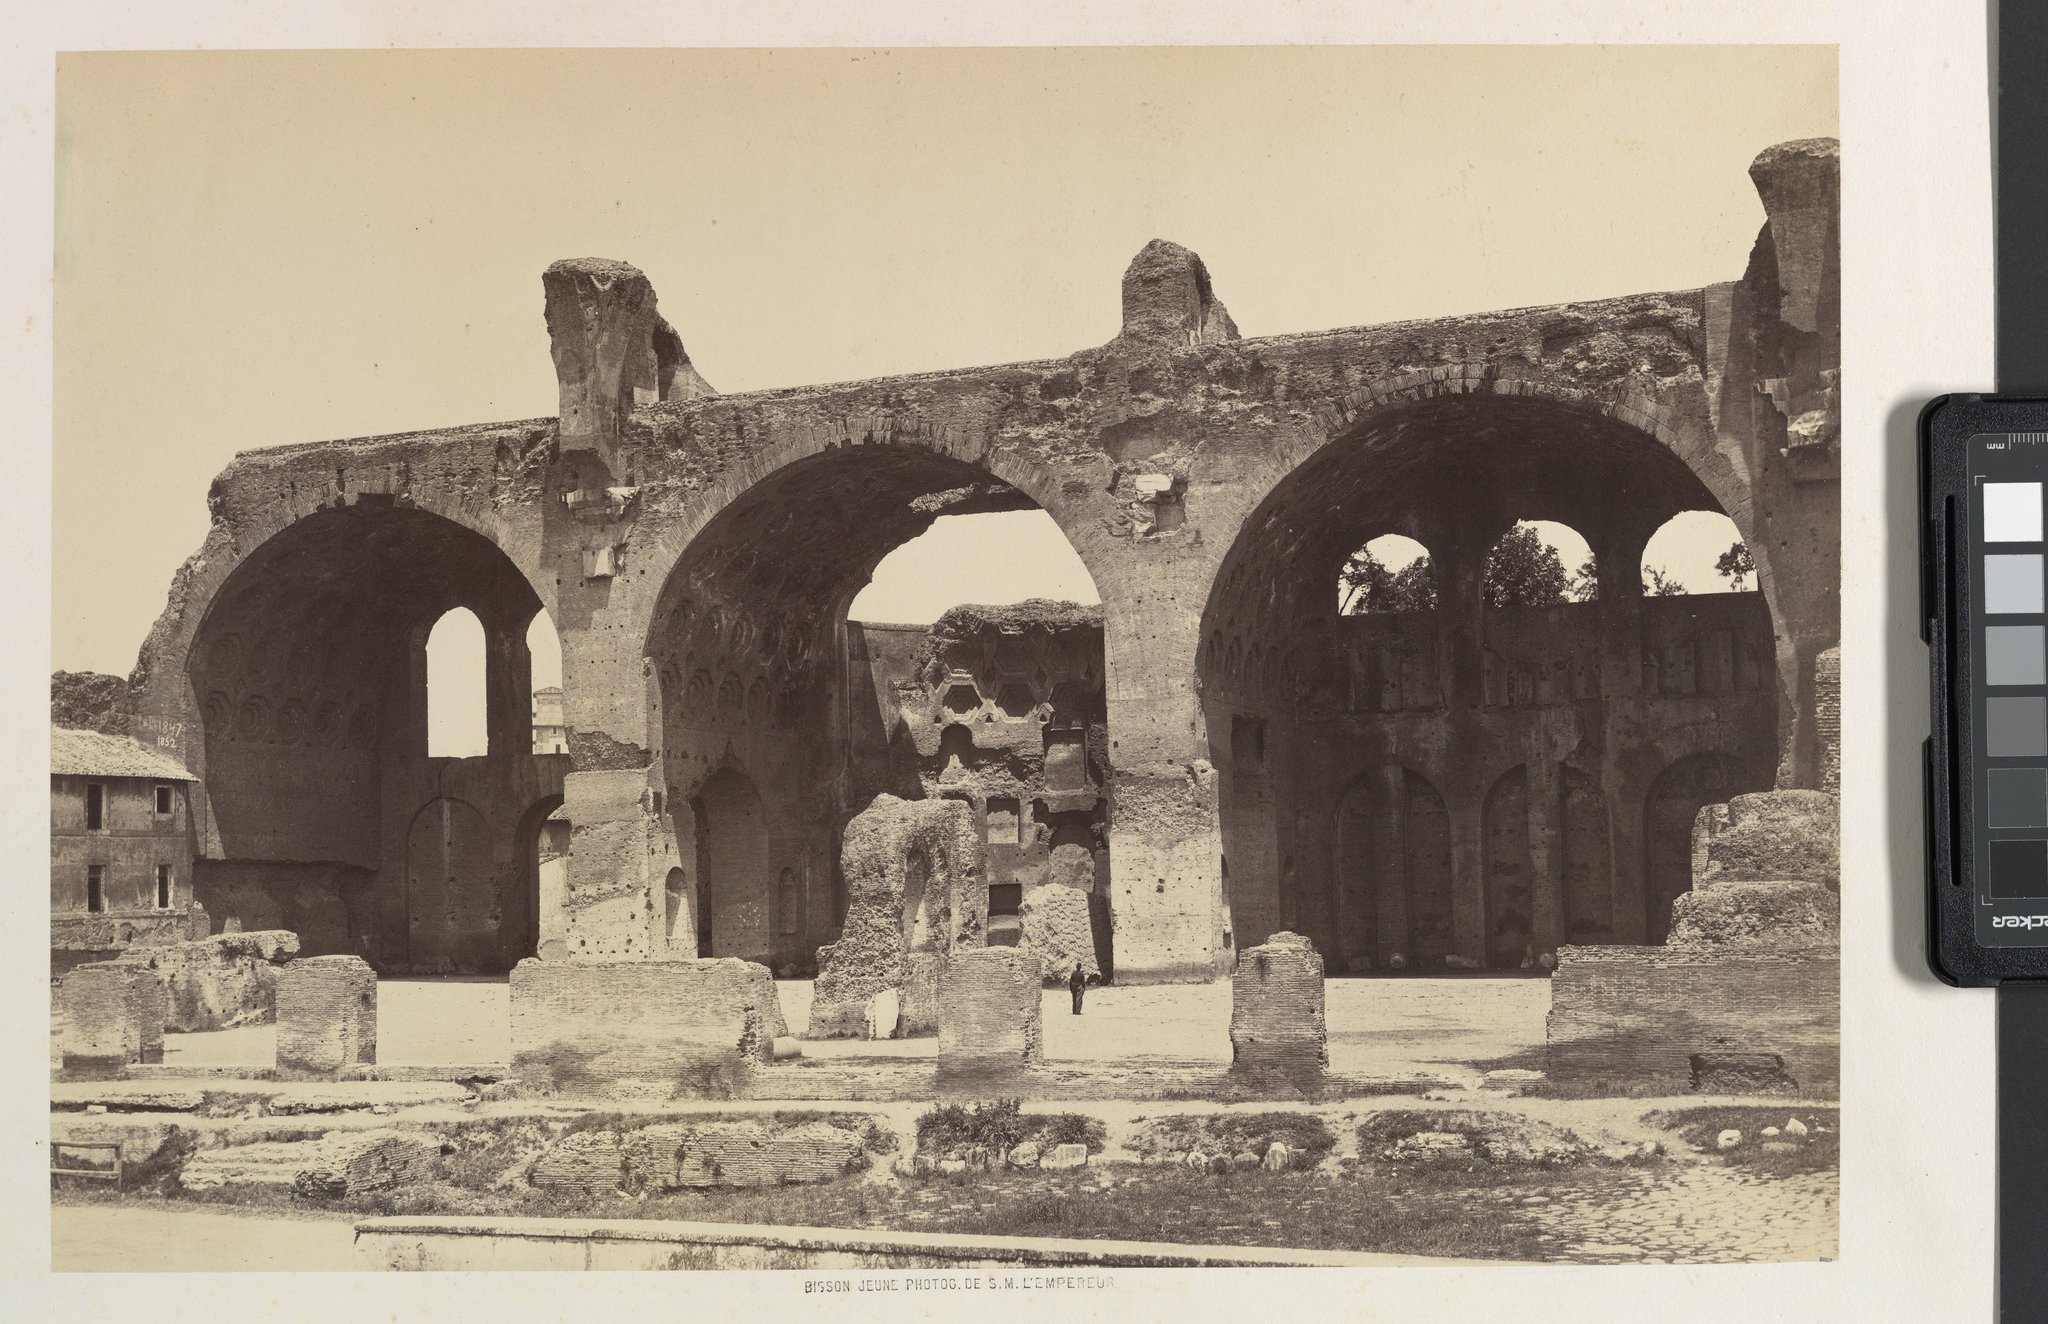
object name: photograph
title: [Basilica of Maxentius and Constantine, Rome]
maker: auguste-rosalie bisson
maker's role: artist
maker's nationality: french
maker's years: 1826-1900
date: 1861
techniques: albumen silver print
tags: architecture,arches,ruins